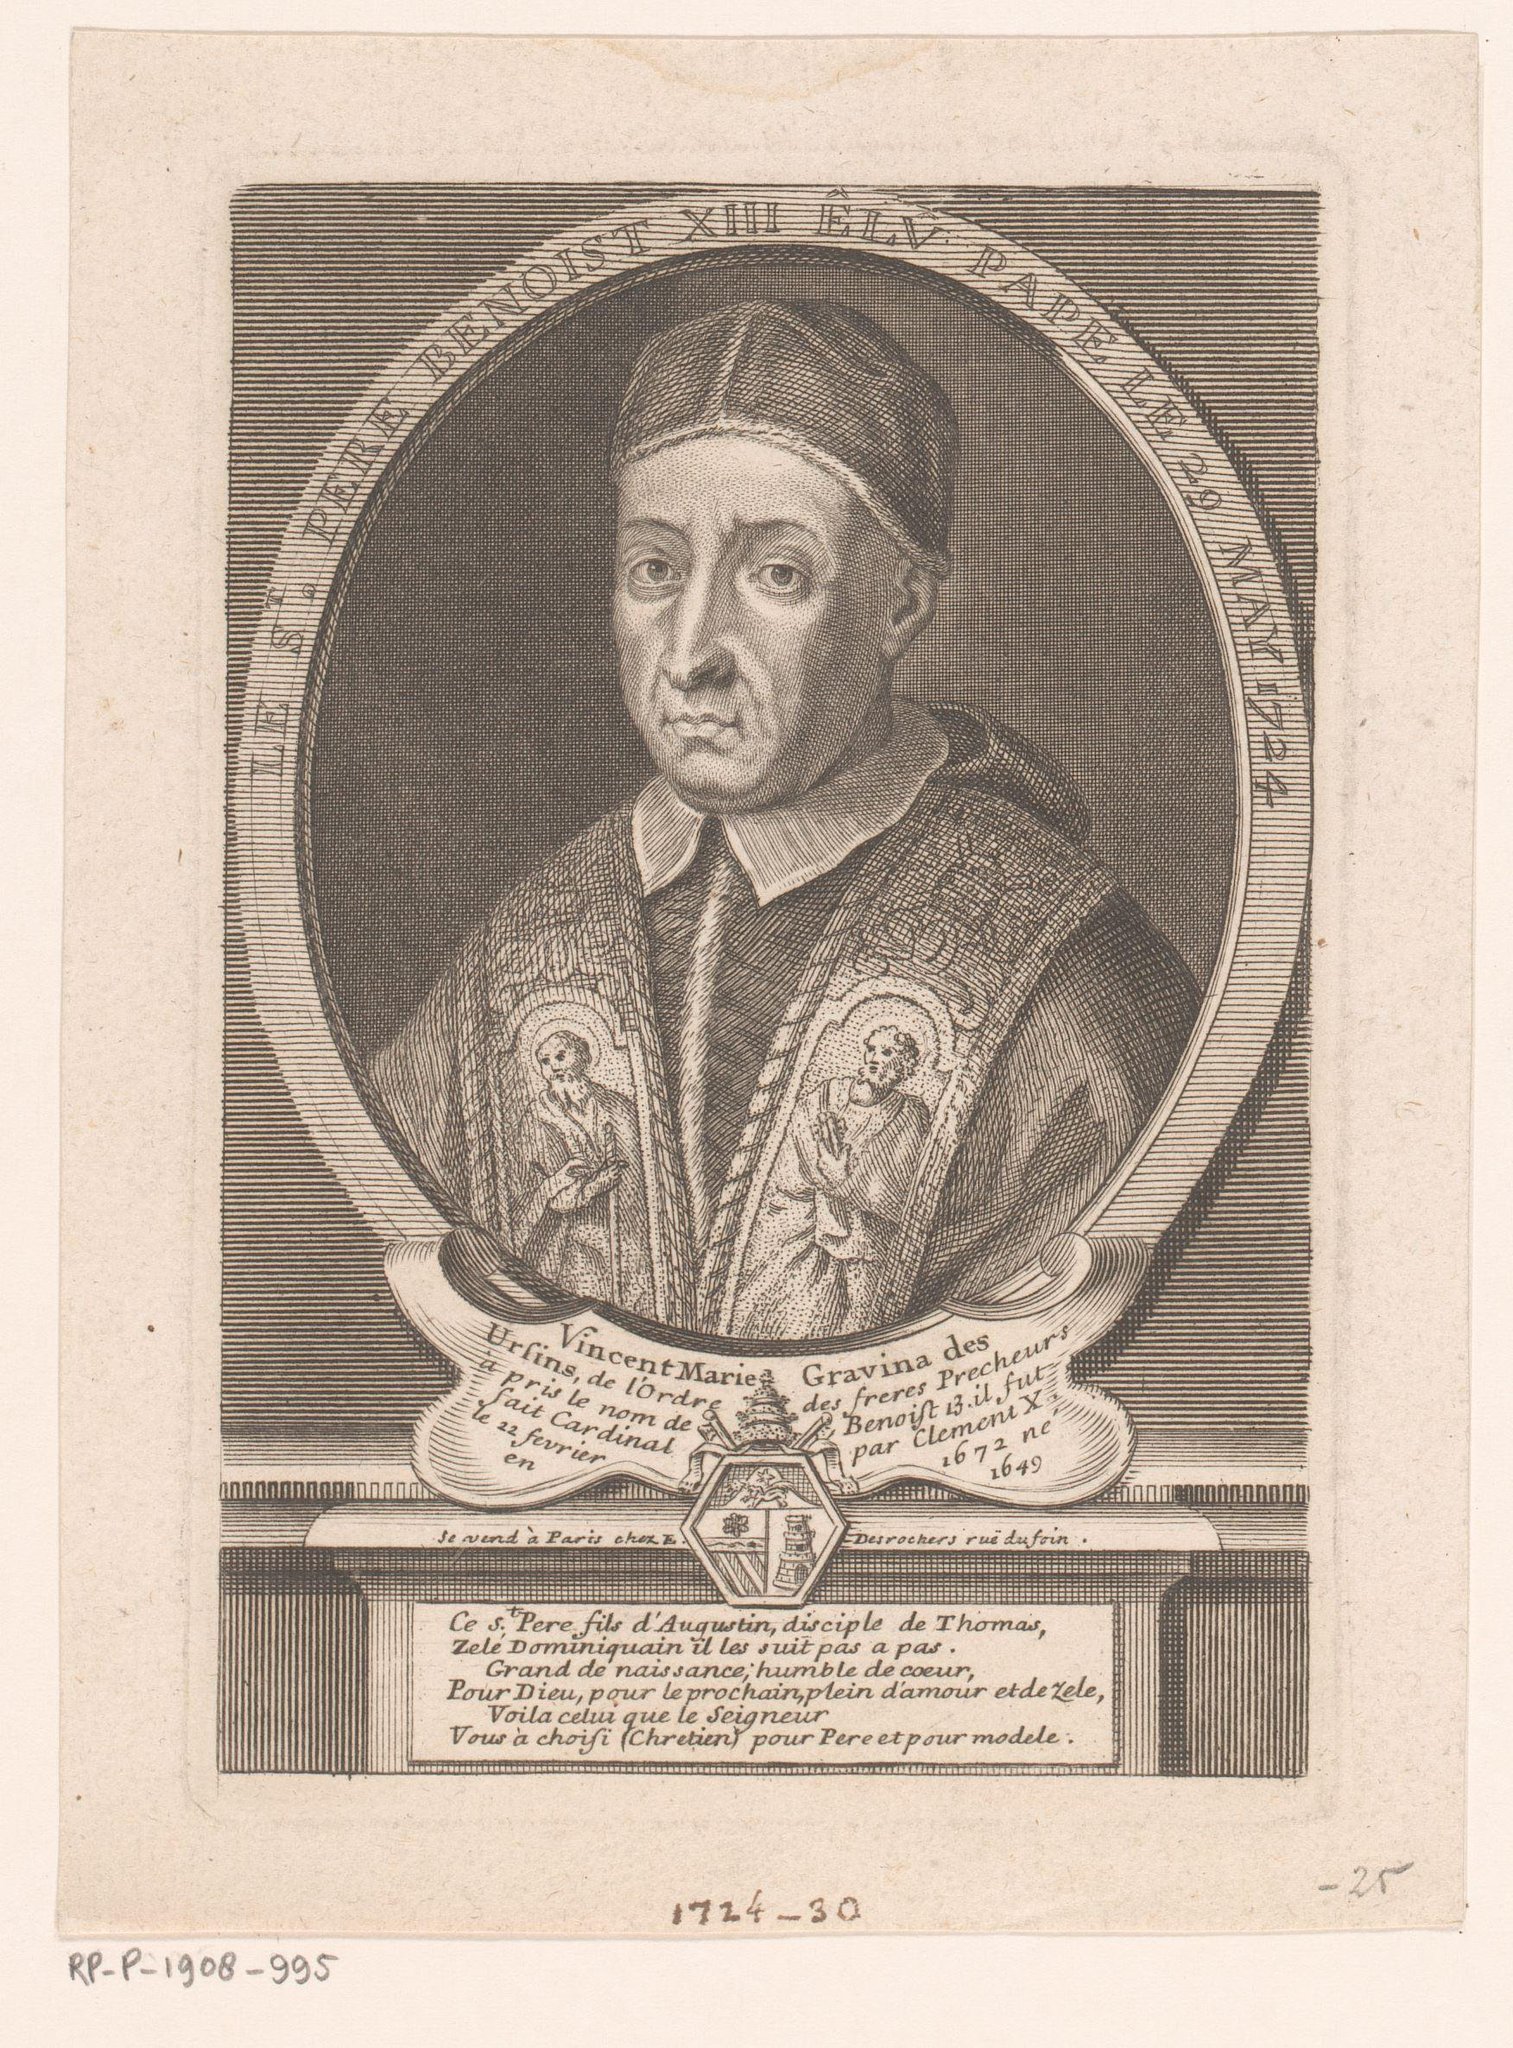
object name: print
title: Verzameling portretten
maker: étienne desrochers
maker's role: print maker, publisher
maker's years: 1668-1741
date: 1726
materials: paper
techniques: engraving, etching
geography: paris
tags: benedictus xiii, historical persons, pope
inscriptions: collector's mark: Lugt 2228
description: Behoort waarschijnlijk tot een serie portretten, grotendeels door Etienne Desrochers, getiteld: 'Recueil de portraits de personnes qui se sont distinguées tant dans les Armes que dans Belles-Lettres et les Arts, comme aussi la famille royale de France et autres cours étrangères'. De serie werd initieel uitgegeven door Desrochers en aangekondigd in 'Mercure' in mei 1726, p. 985. Echter was Desrochers reeds enkele jaren eerder begonnen met het uitgeven van de serie. Na de dood van Desrochers werd de serie voortgezet door Gilles Edme Petit. Een latere staat werd uitgegeven door Jean François Daumont in Parijs.